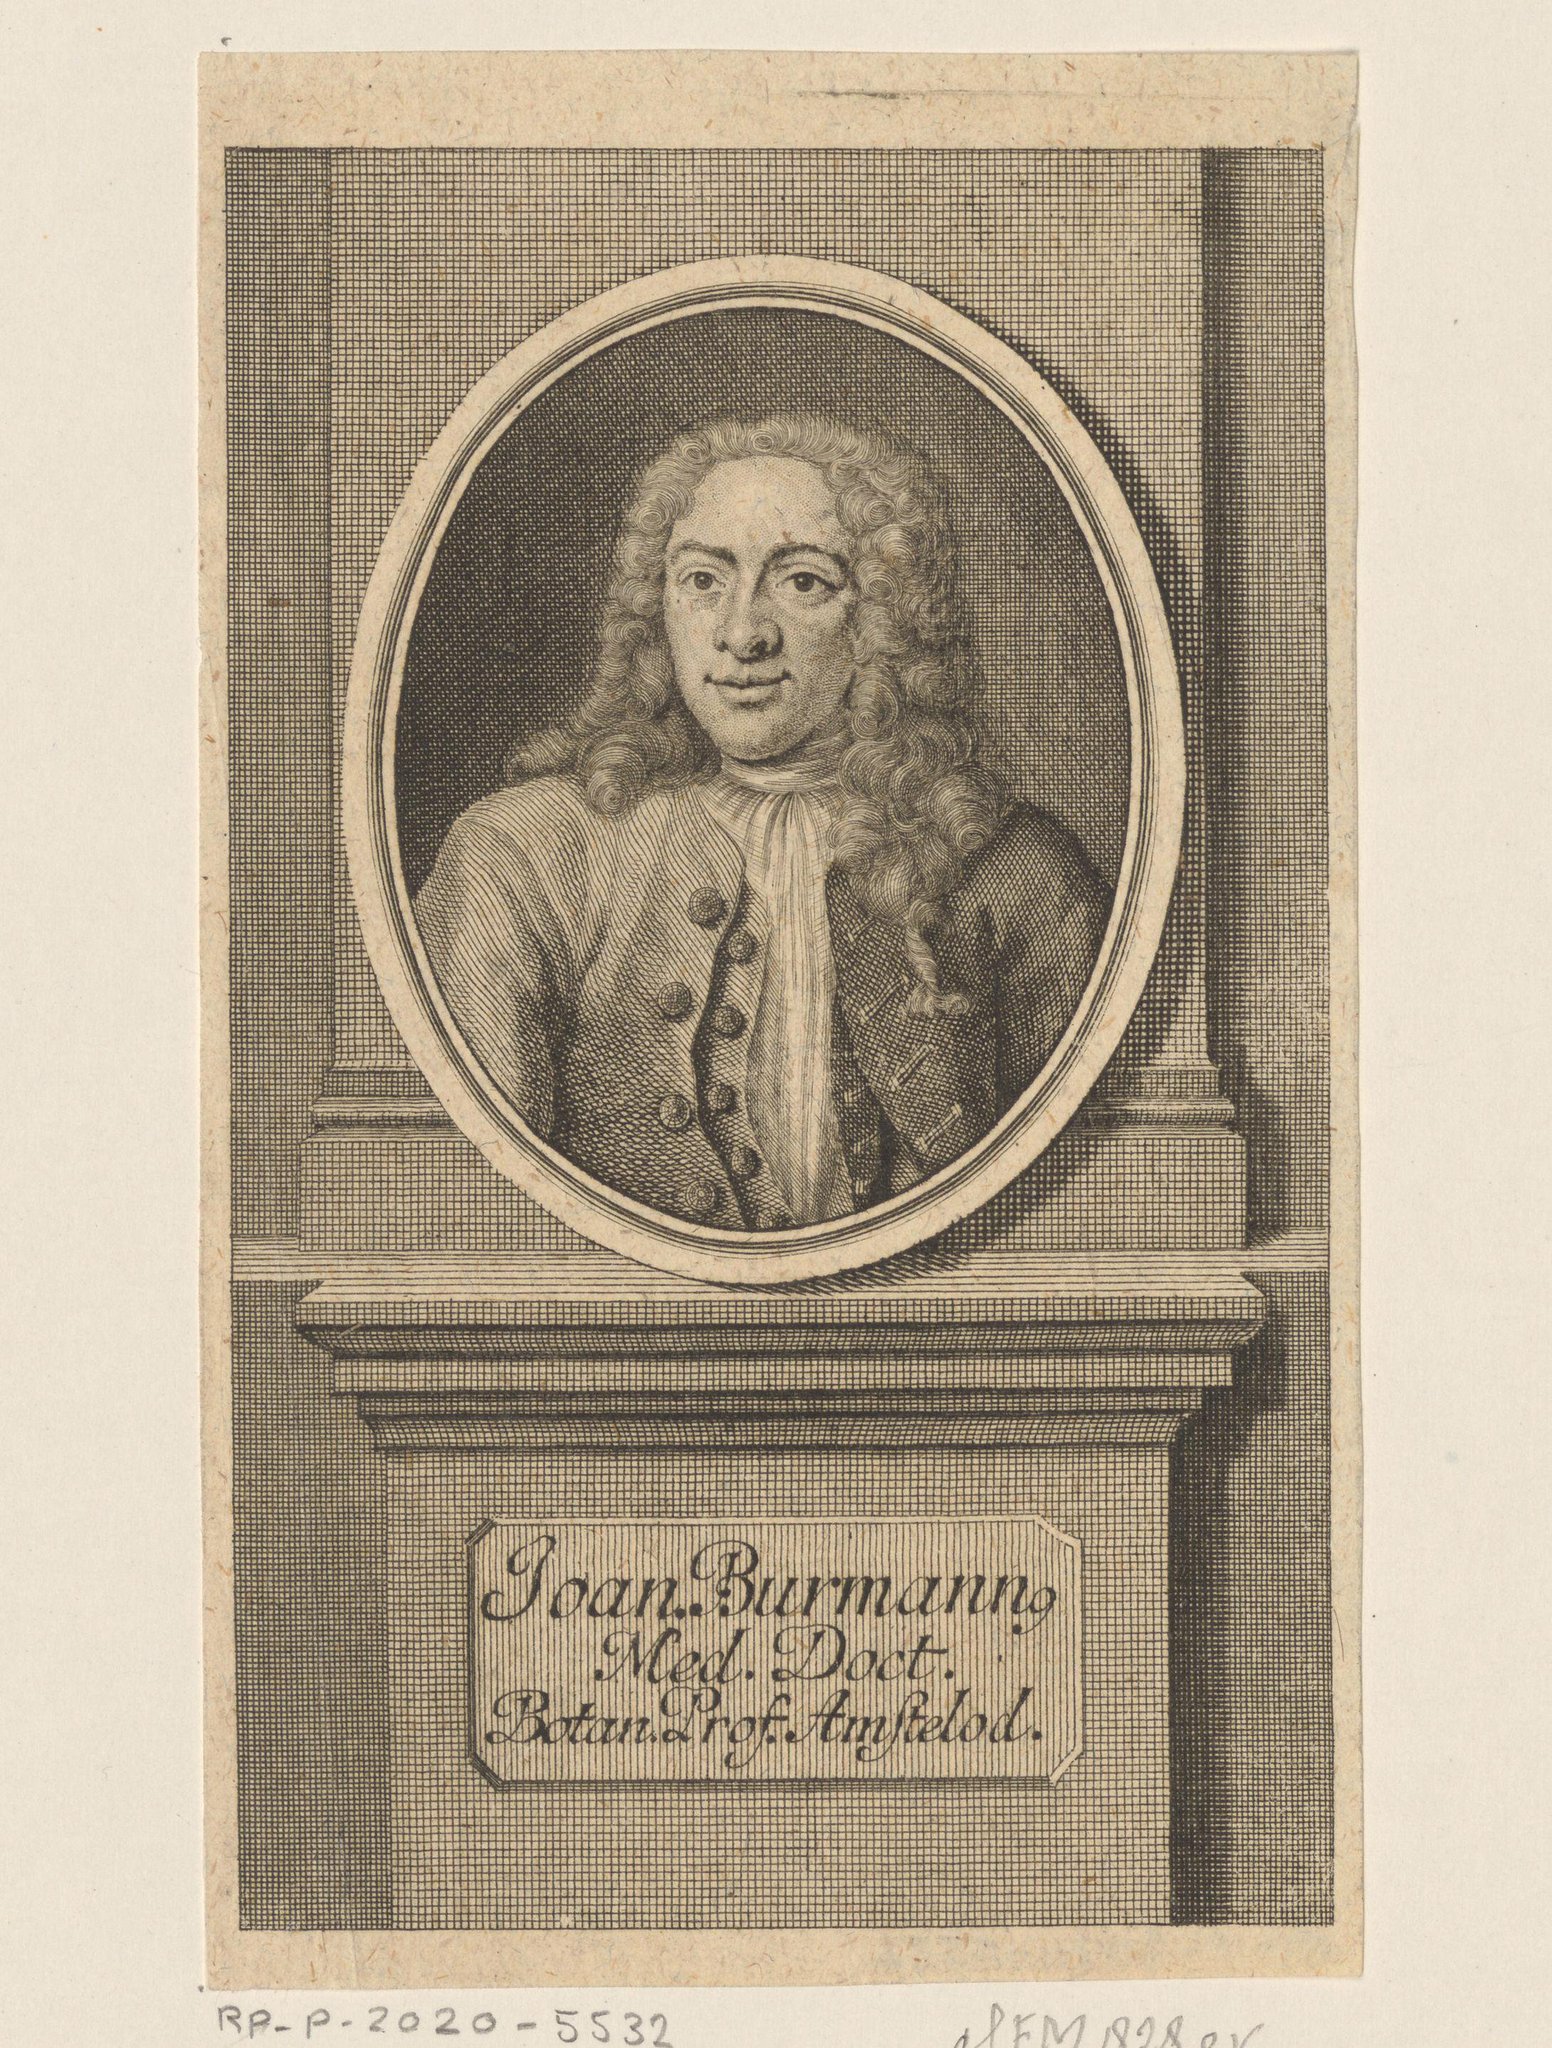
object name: print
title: Portret van Johannes Burman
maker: Anonymous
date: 1728-1750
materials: paper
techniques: engraving, etching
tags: historical persons, physician, doctor